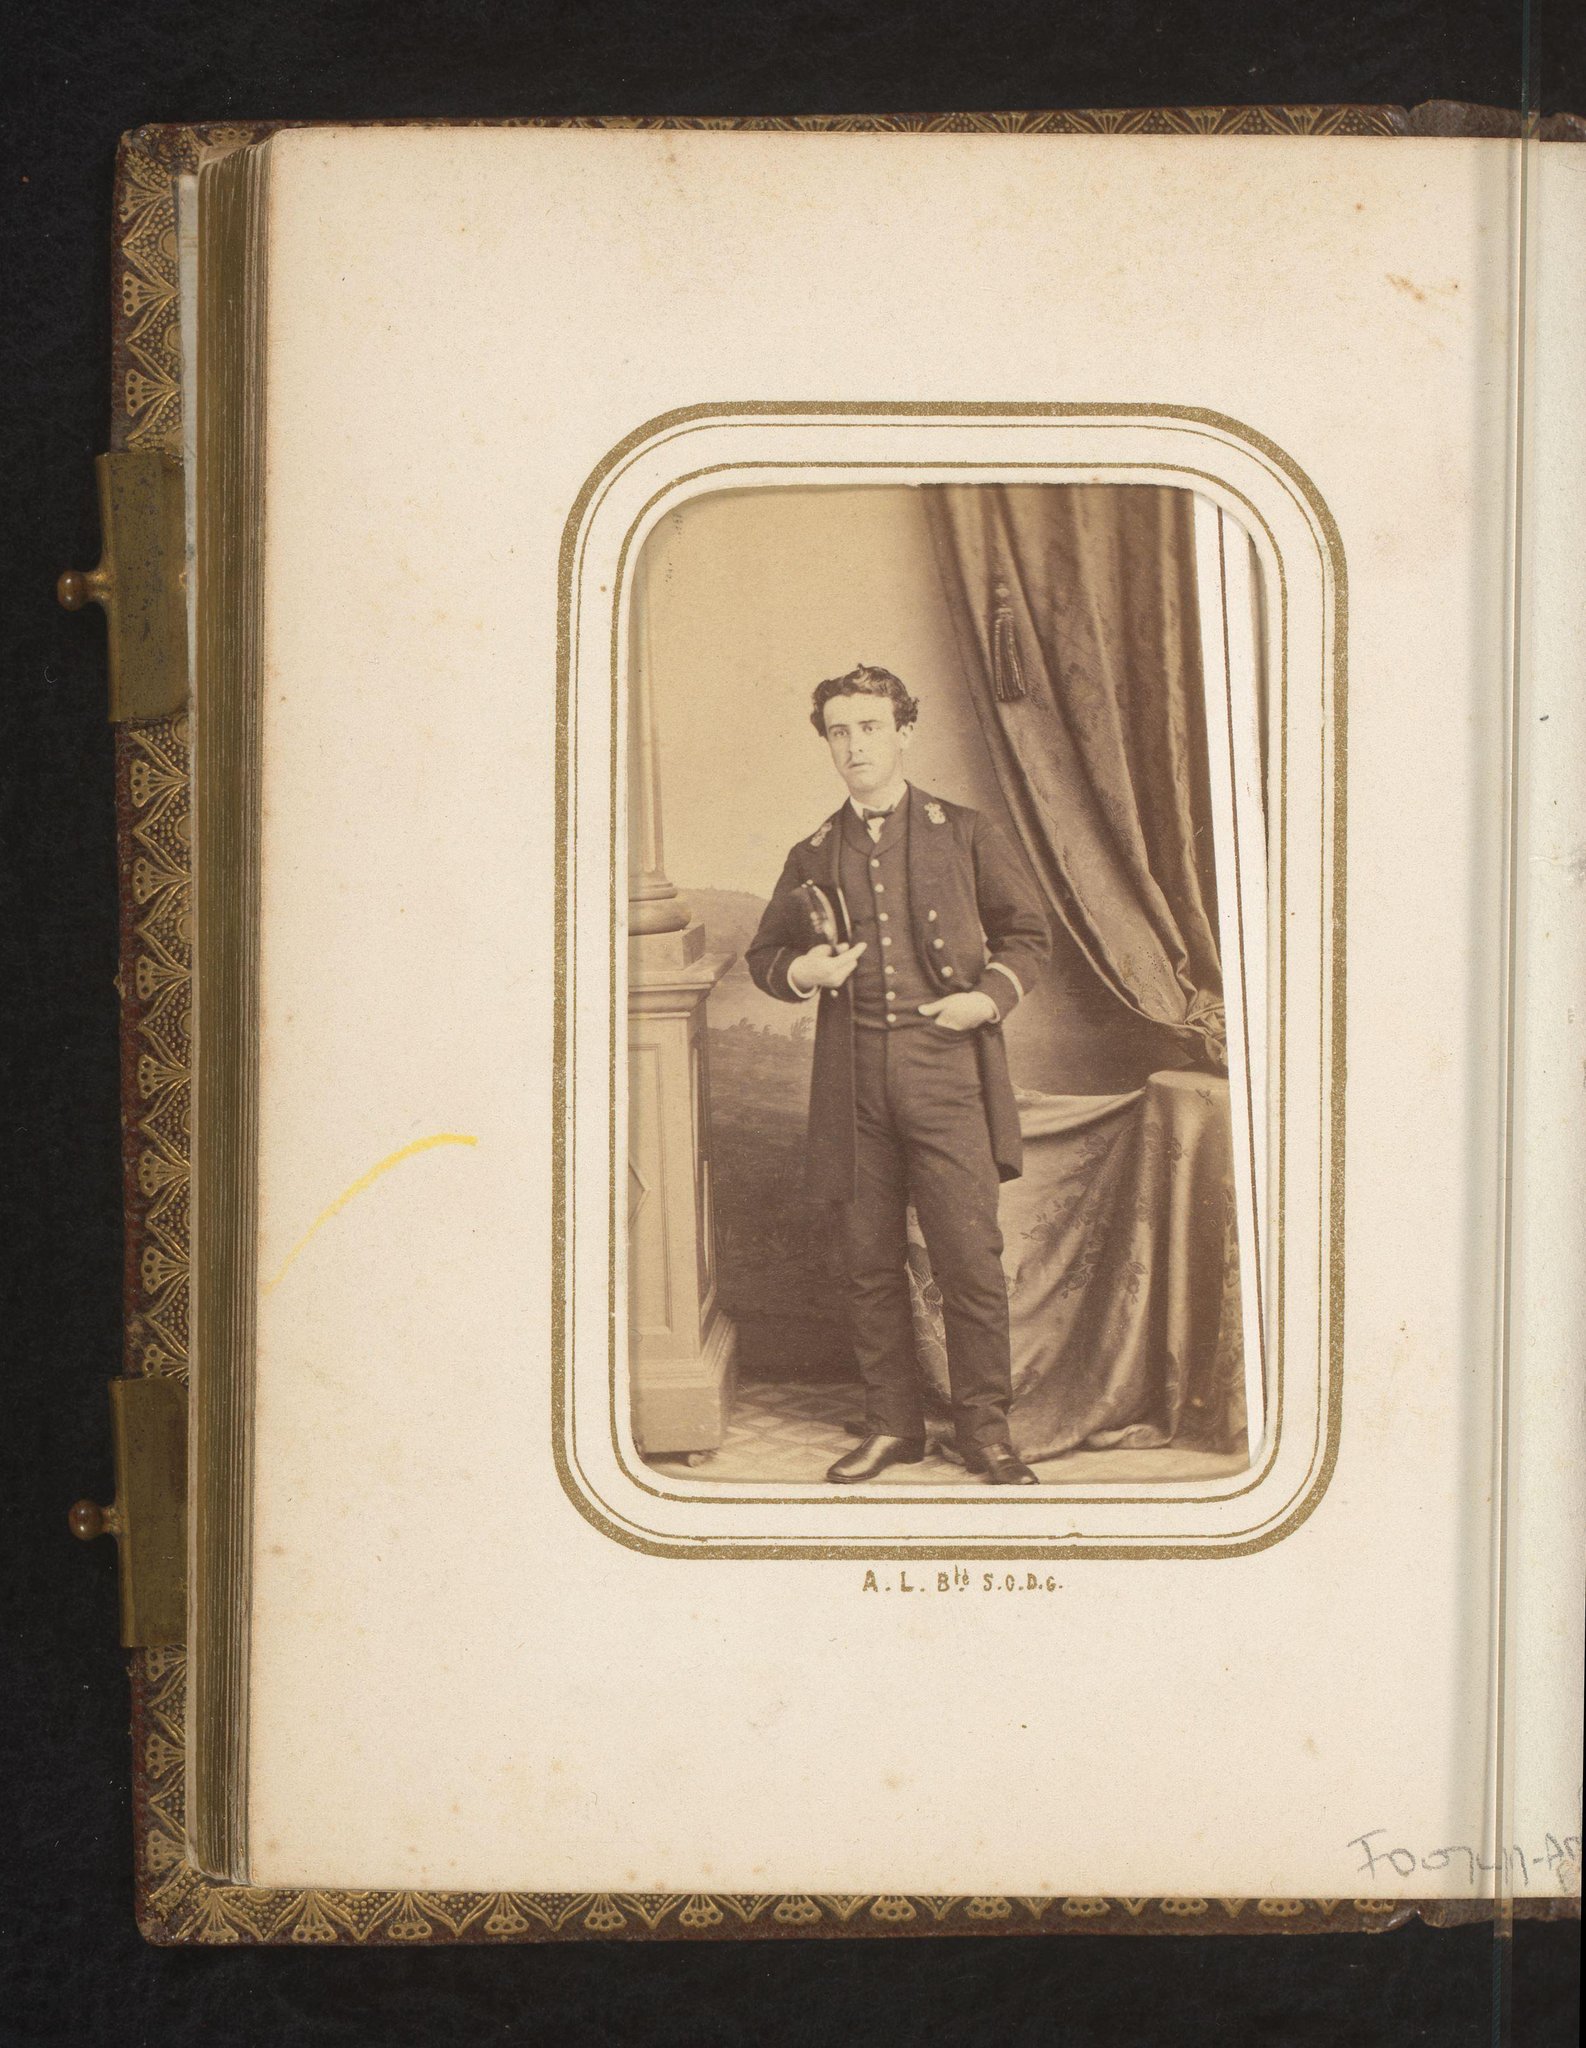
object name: album leaf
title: Portret staande jongeman in marine uniform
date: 1860-1870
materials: cardboard, photographic support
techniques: albumen print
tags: adult man, historical persons, (military) uniforms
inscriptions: inscription: ‘Fotografia del puerto/ J.B. Varonne y Cia/ Fotografo/ Calle del 25 de Agusto No 102 y 104/ Montevideo’, inscription: ‘A.L. B.te S.C.D.G.’